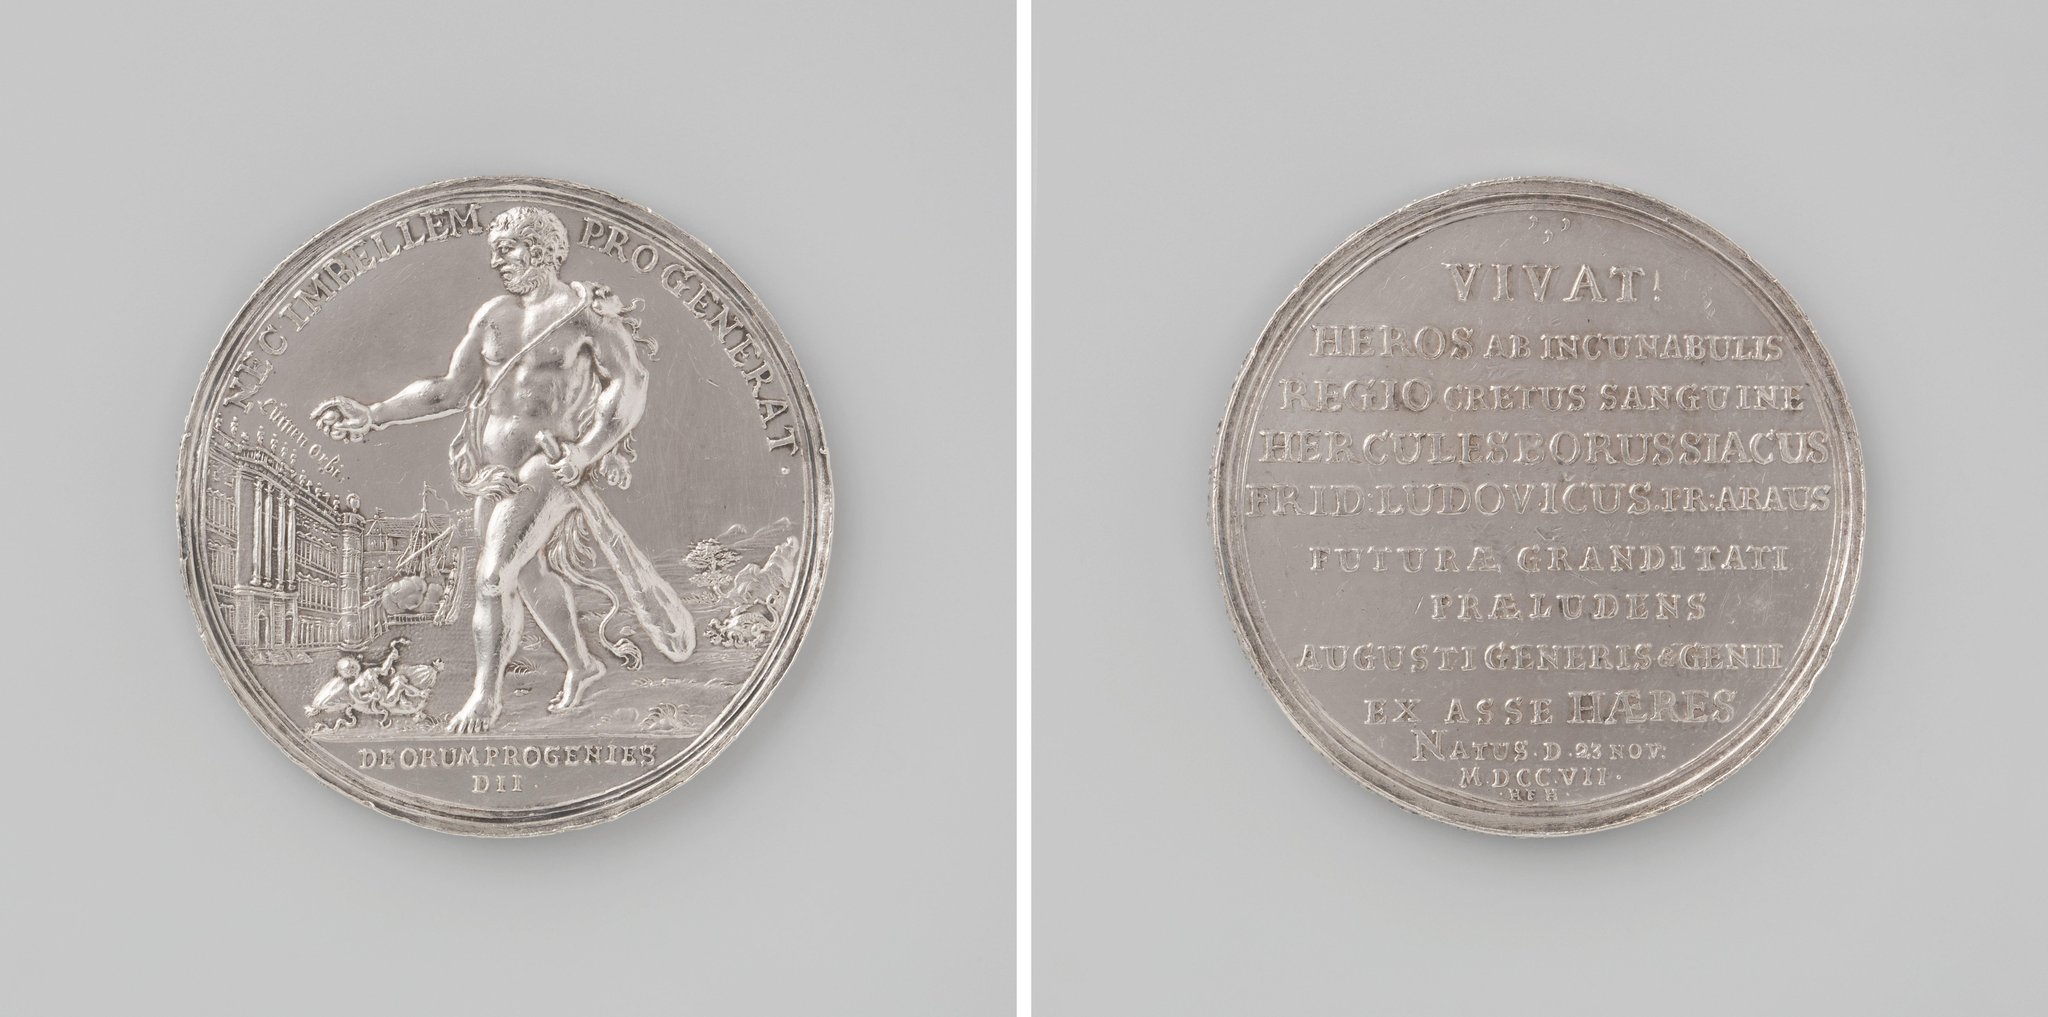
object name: history medal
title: Geboorte van Frederik Lodewijk van Pruisen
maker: heinrich friedrich halter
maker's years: 1698-1719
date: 1707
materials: silver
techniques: striking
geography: magdeburg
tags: frederik lodewijk (erfprins van pruisen)